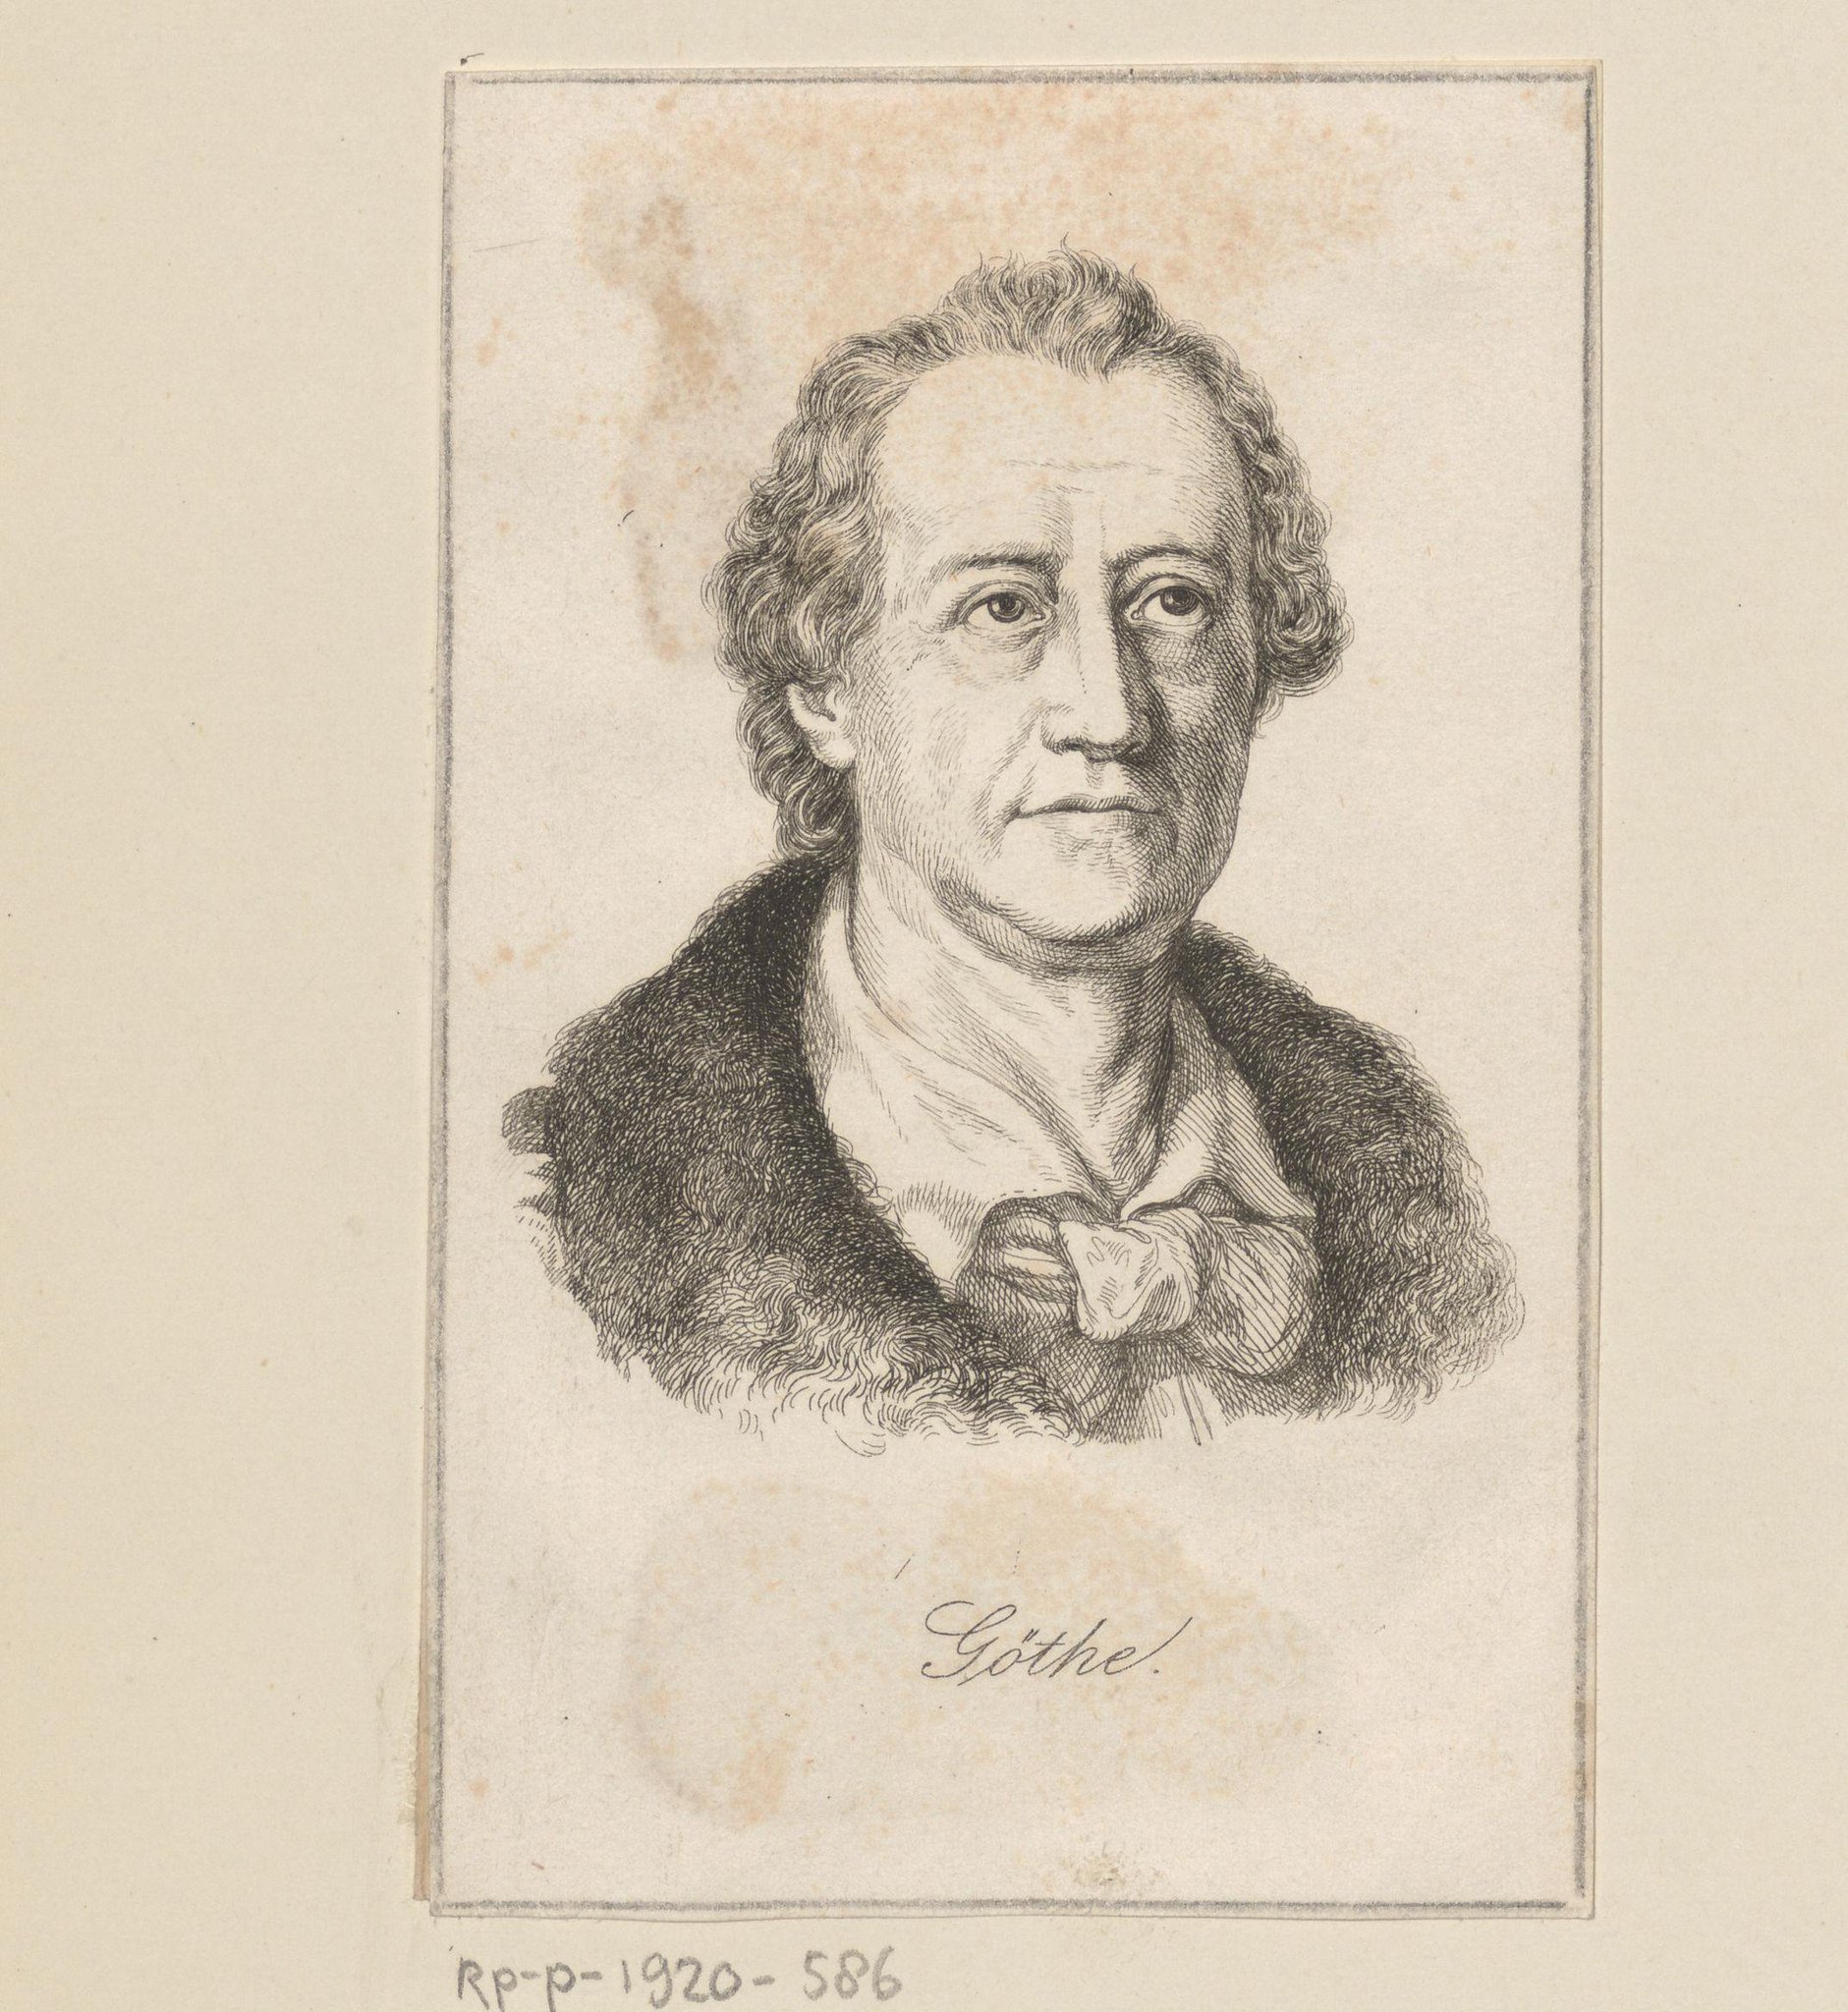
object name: print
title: Portret van Johann Wolfgang von Goethe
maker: Anonymous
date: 1780-1880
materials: paper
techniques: engraving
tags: draughtsman, johann wolfgang von goethe, historical persons, portrait of a writer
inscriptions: collector's mark: Lugt 2228